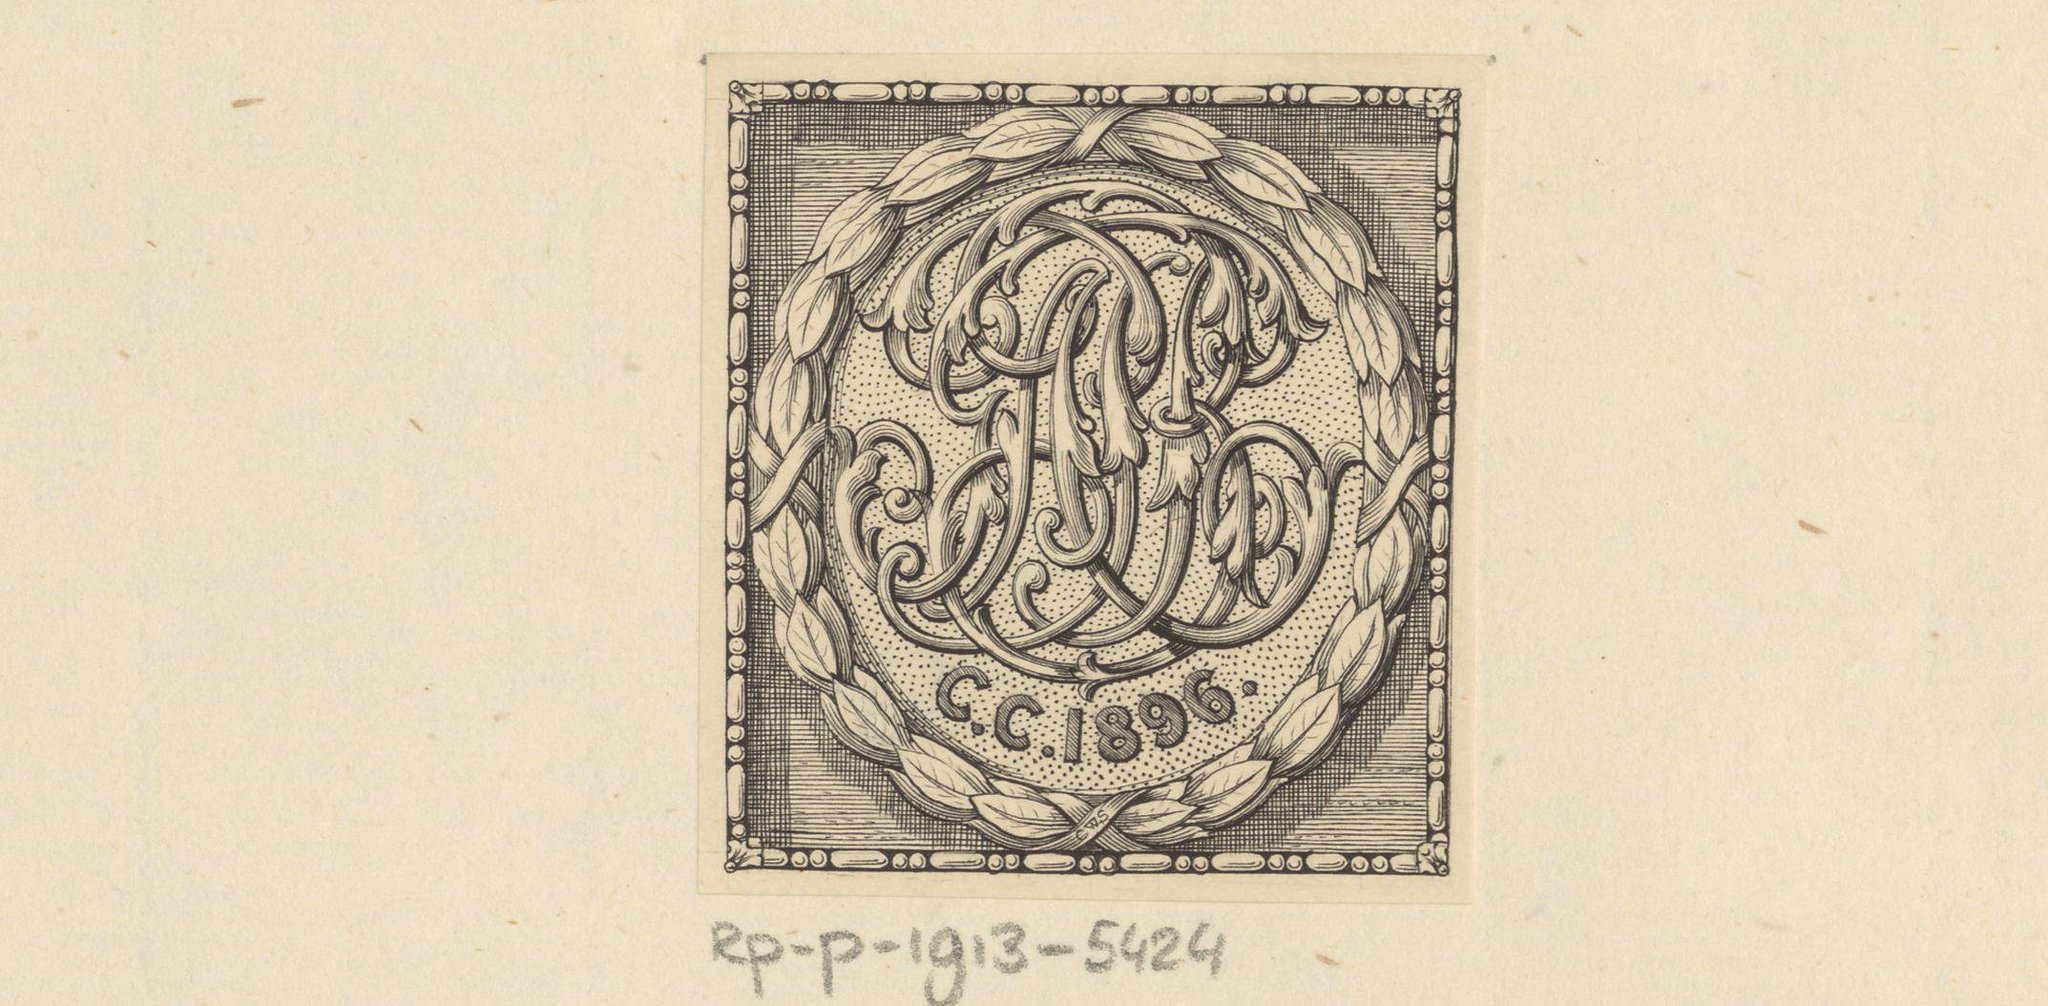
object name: bookplate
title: Ex libris van Geoffrey Ambrose Phillipps Brown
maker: charles william sherborn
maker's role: print maker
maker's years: 1831-1912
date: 1896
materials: paper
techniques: engraving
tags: letter combinations such as letterword, anagram, letter square, monogram, etc.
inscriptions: collector's mark: Lugt 2760, collector's mark: Lugt 2233